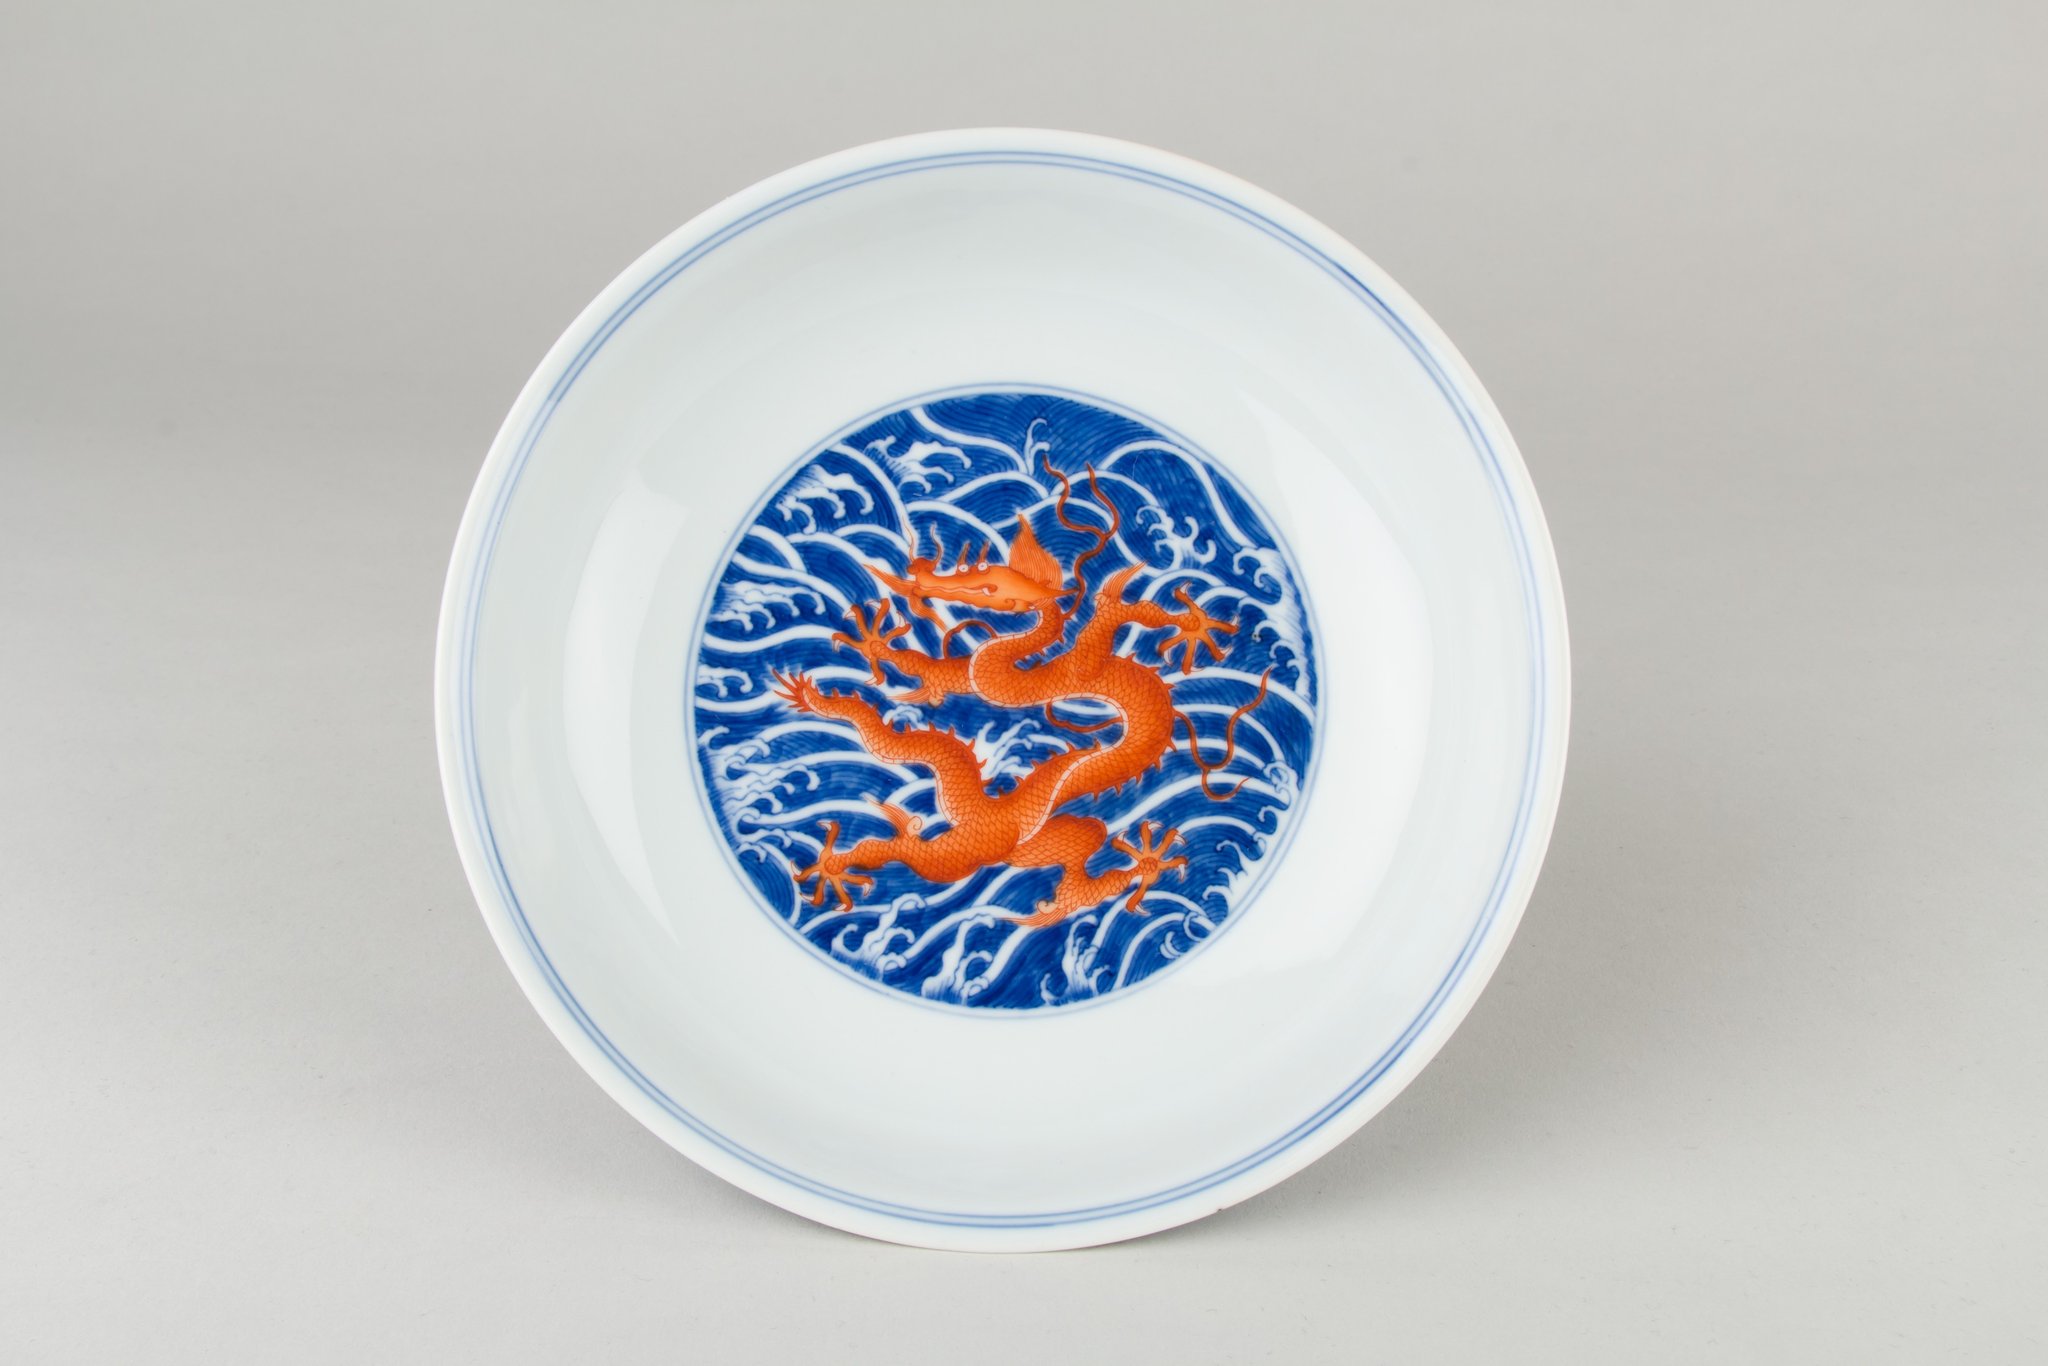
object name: dish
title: Dish (one of a pair)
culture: chinese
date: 1736-1795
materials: porcelain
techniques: overglaze, painting, underglaze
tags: dragons